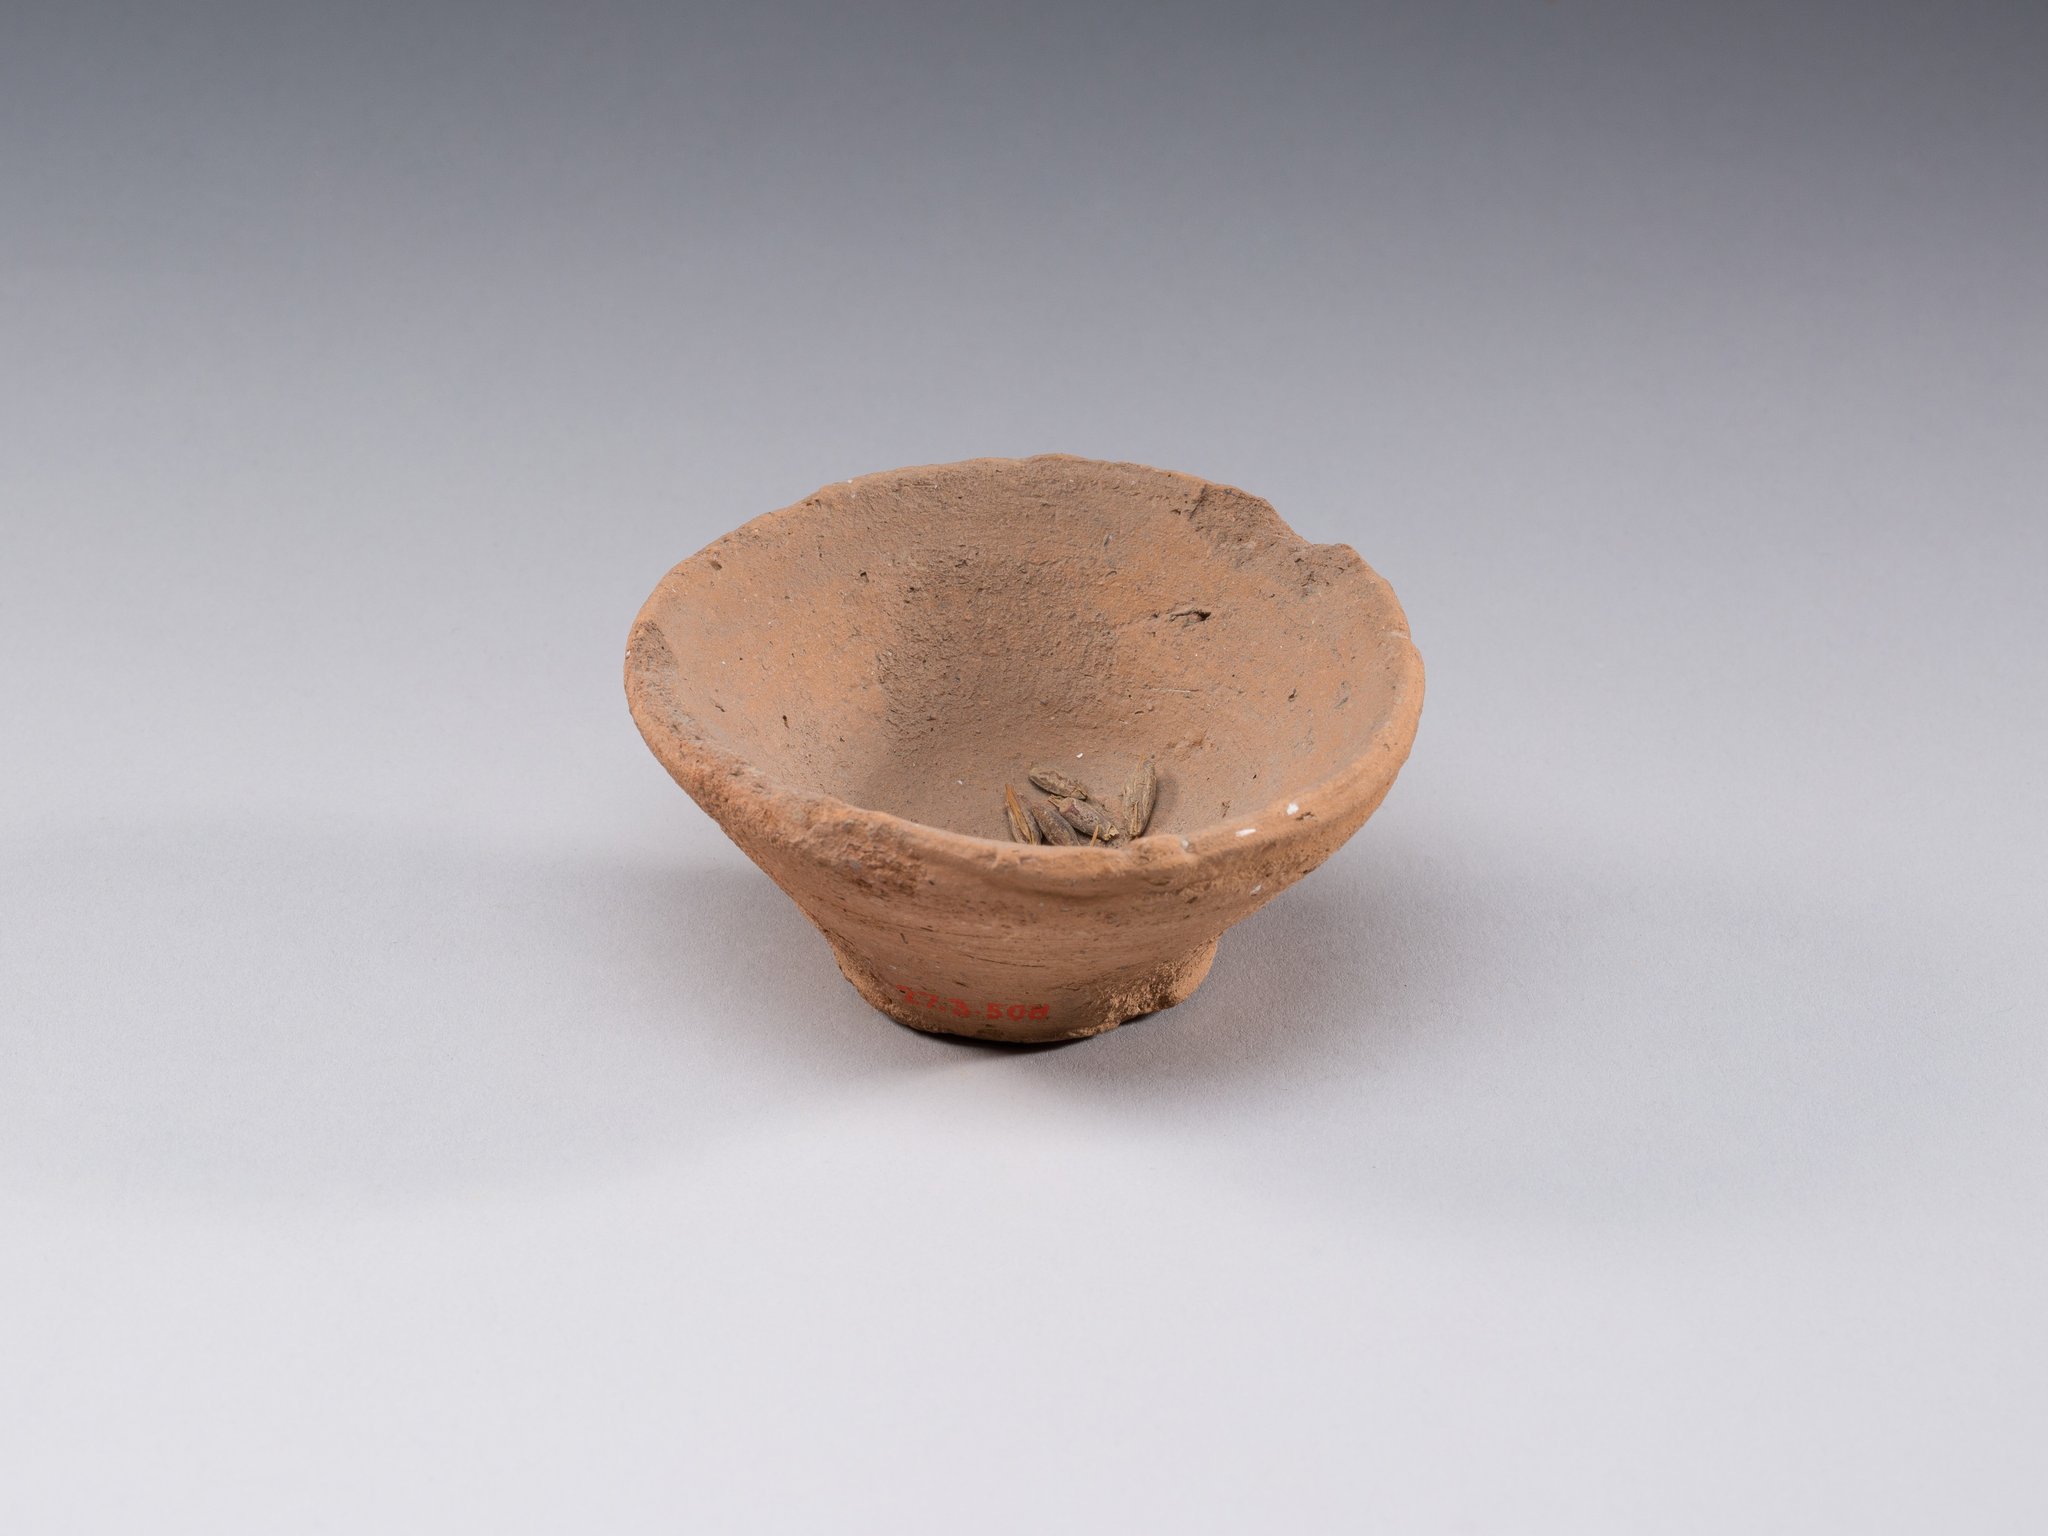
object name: bowl, food, garley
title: Bowl of Barley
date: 1479-1458 BCE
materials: pottery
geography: egypt